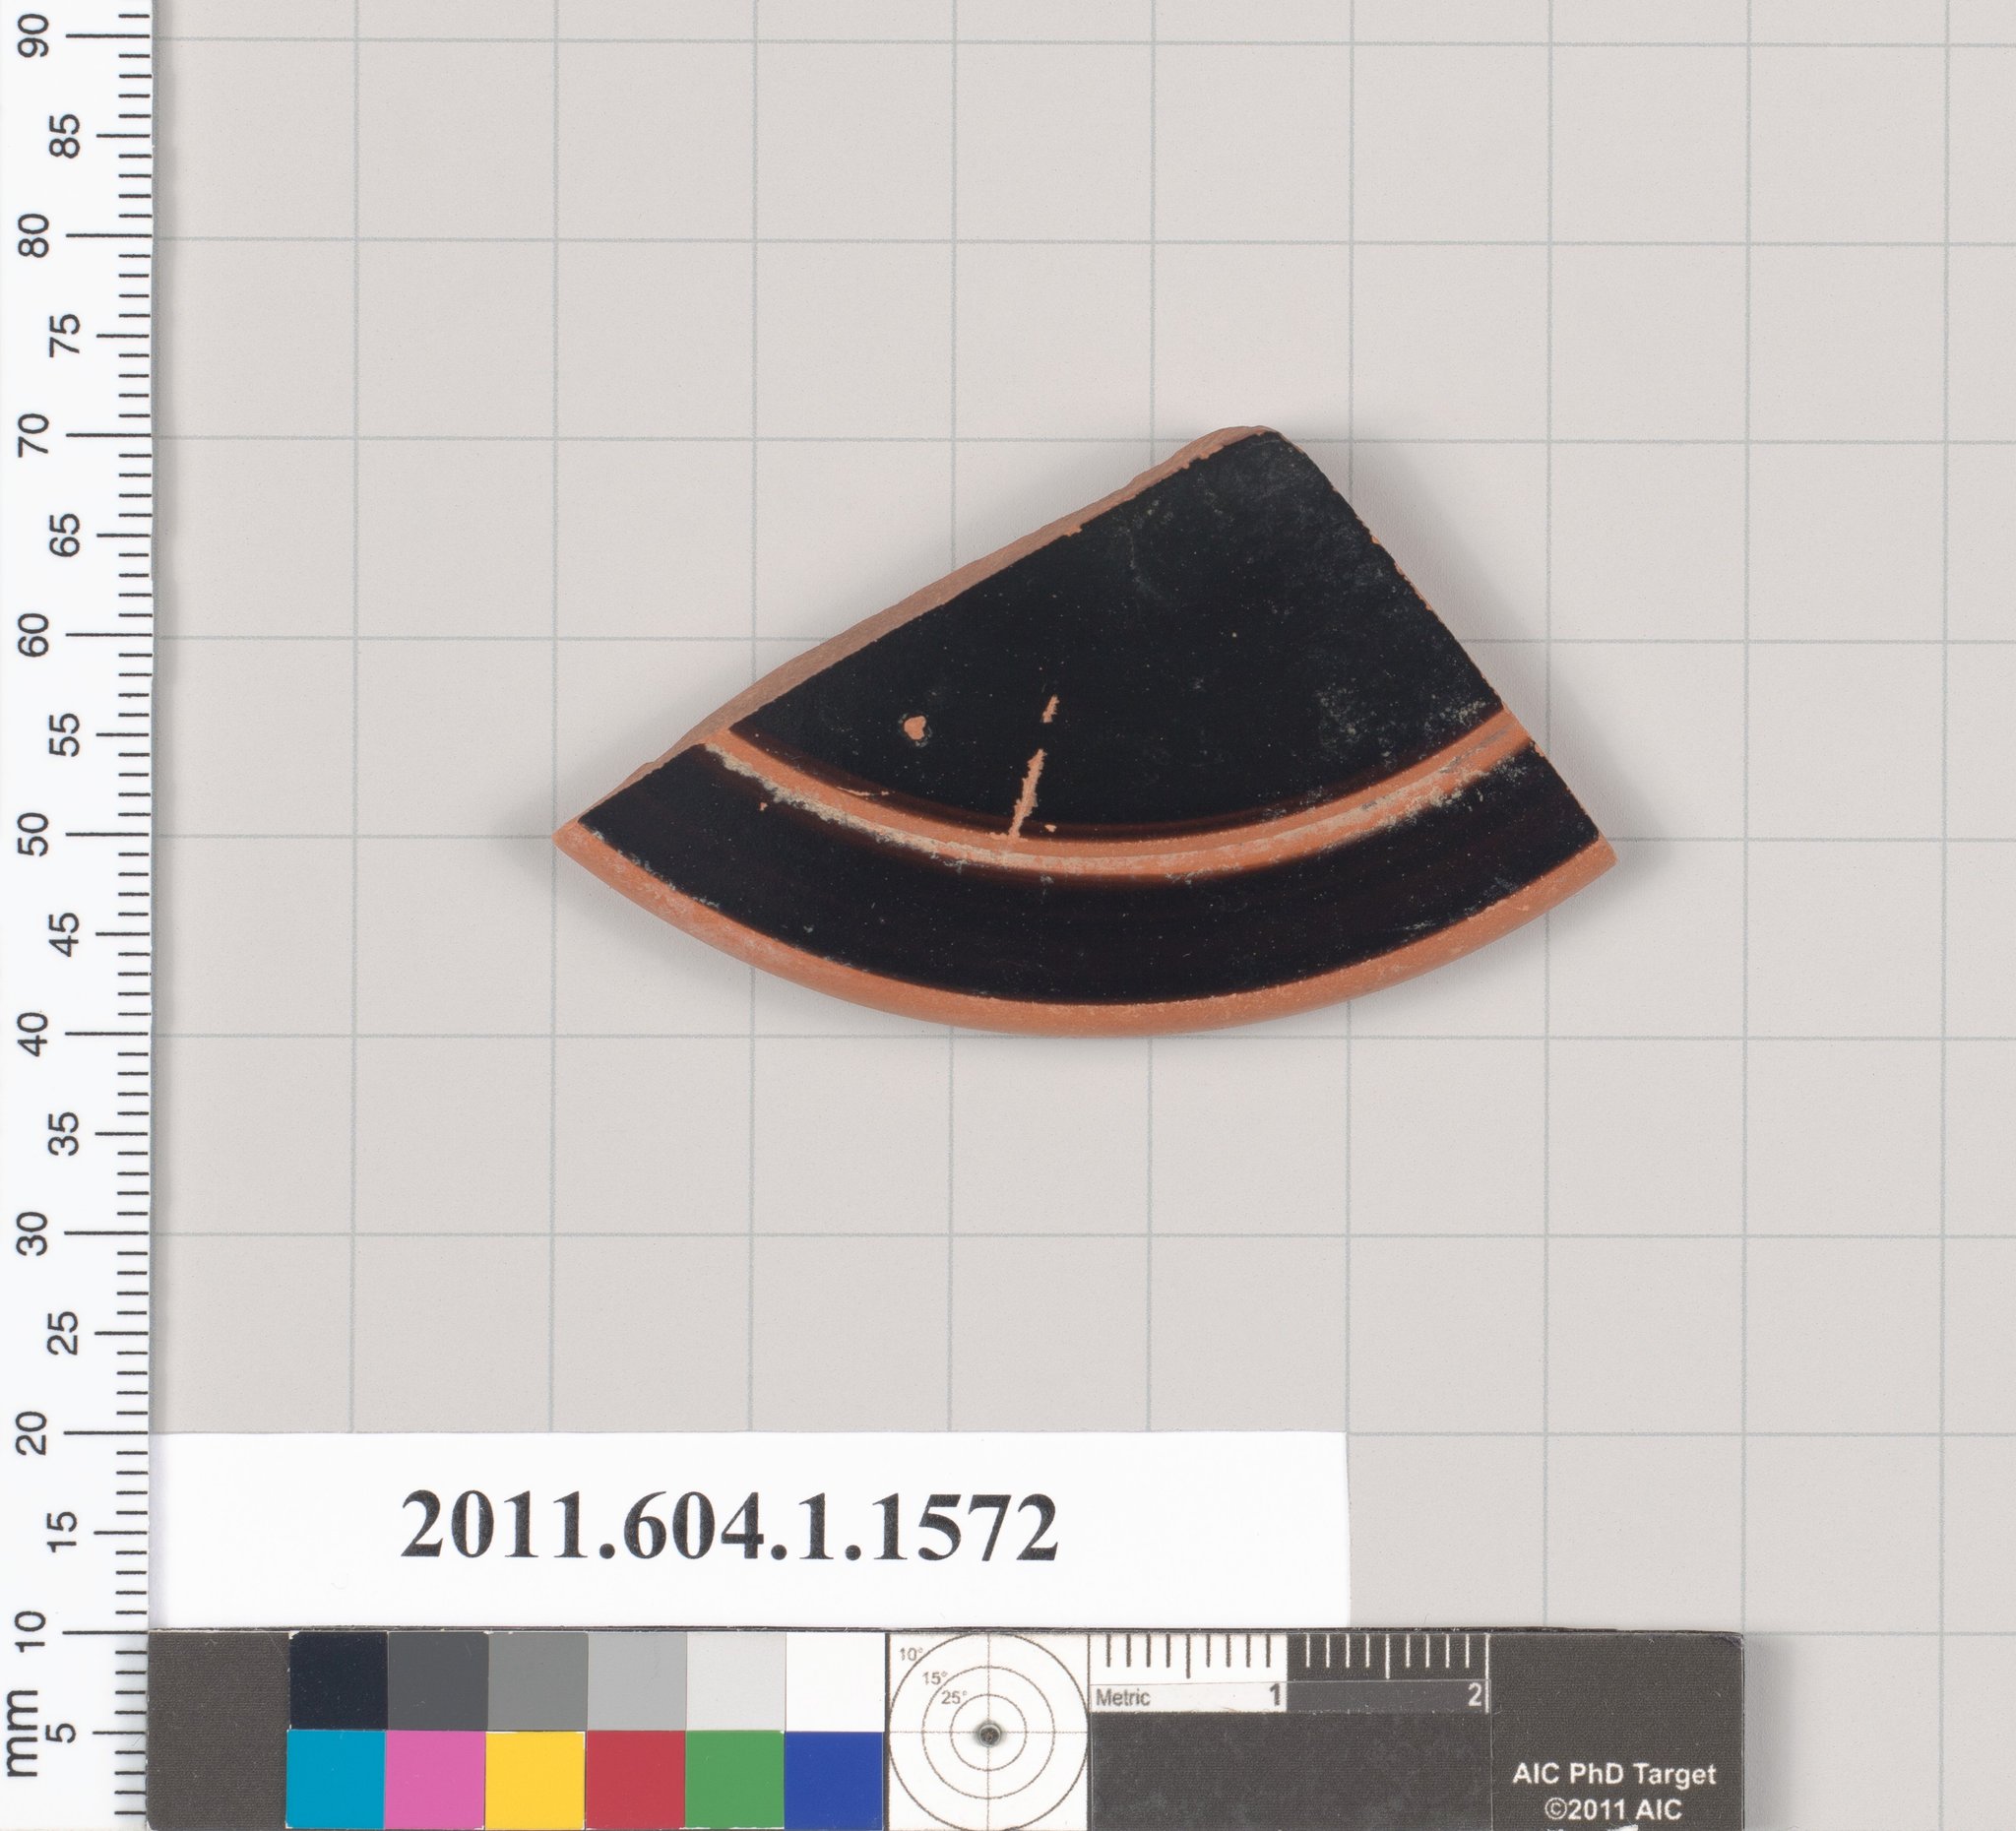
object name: kylix fragment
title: Terracotta fragment of a kylix (drinking cup)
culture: greek, attic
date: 500-401 BCE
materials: terracotta